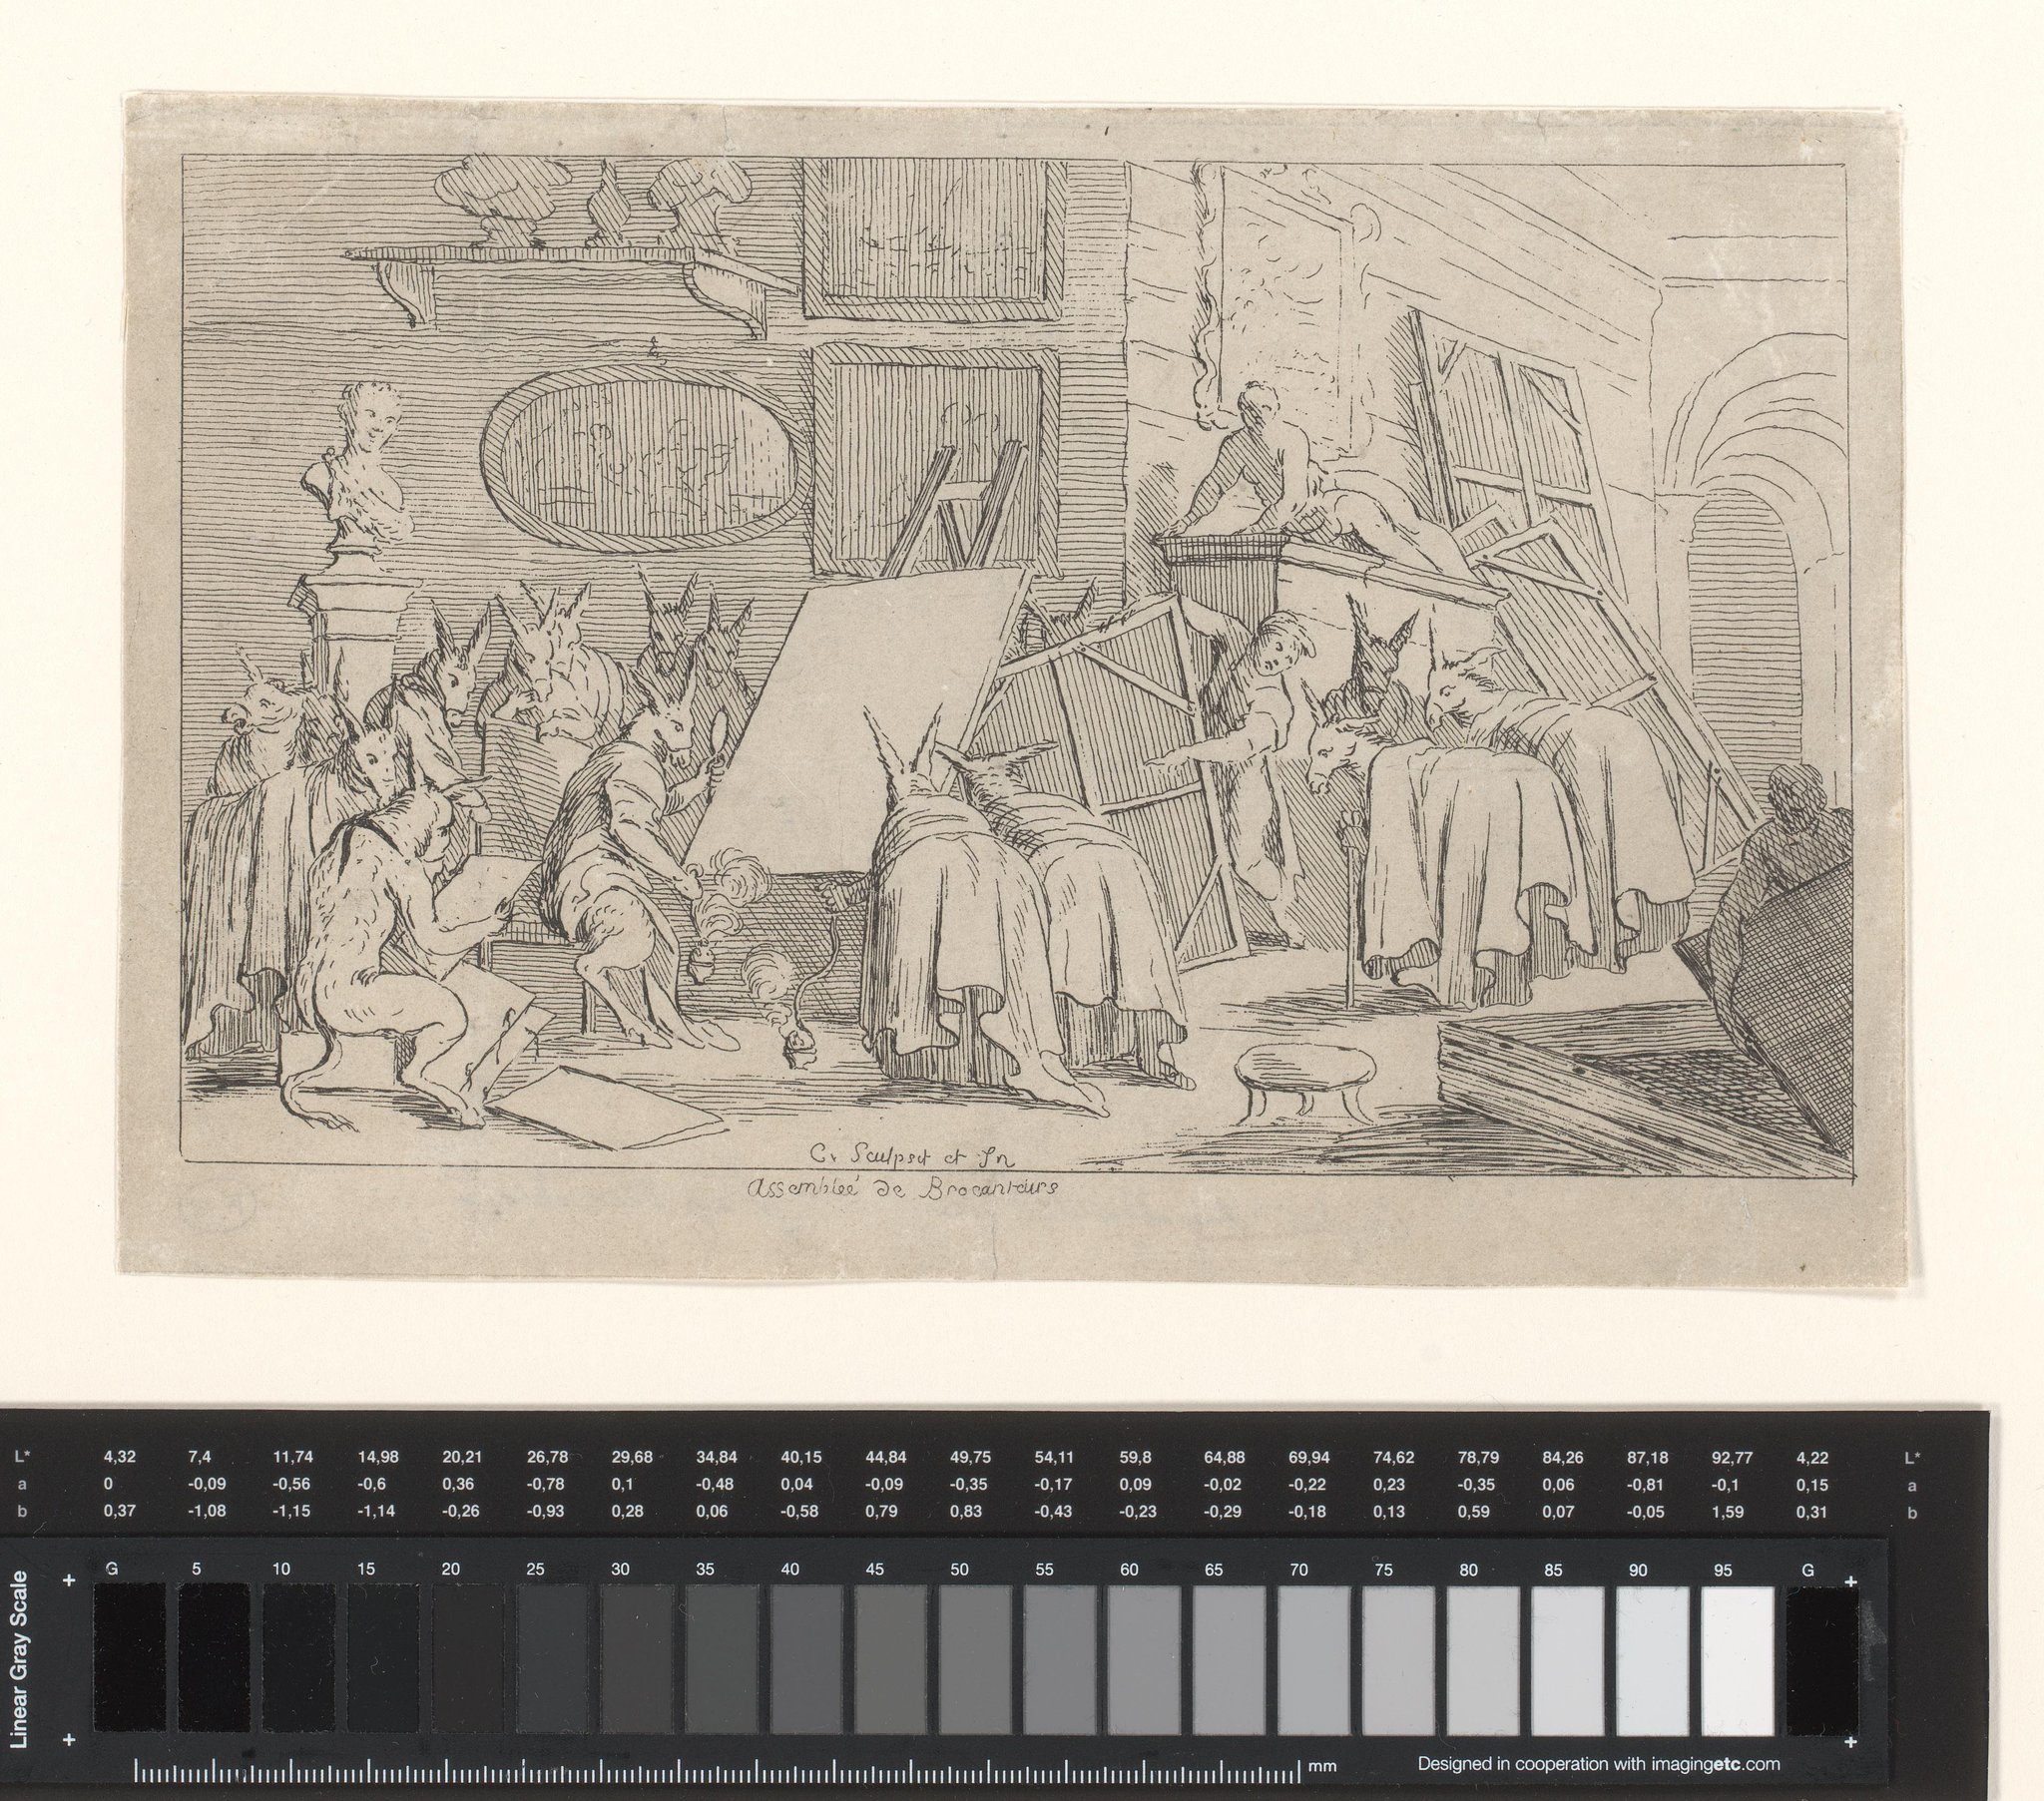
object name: print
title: Assemblée de Brocanteurs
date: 1750-1765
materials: paper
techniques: etching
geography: paris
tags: ass, donkey, art dealer, parody on art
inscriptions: collector's mark: Lugt 2228, collector's mark: Lugt 2760, collector's mark: Lugt 3373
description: Een satire op het kunstbedrijf waarin kunstkenners en handelaren die schilderijen beoordelen zijn voorgesteld als ezels. Naar de tekening van Trémolières in het Hessisches Landes Museum in Darmstadt.